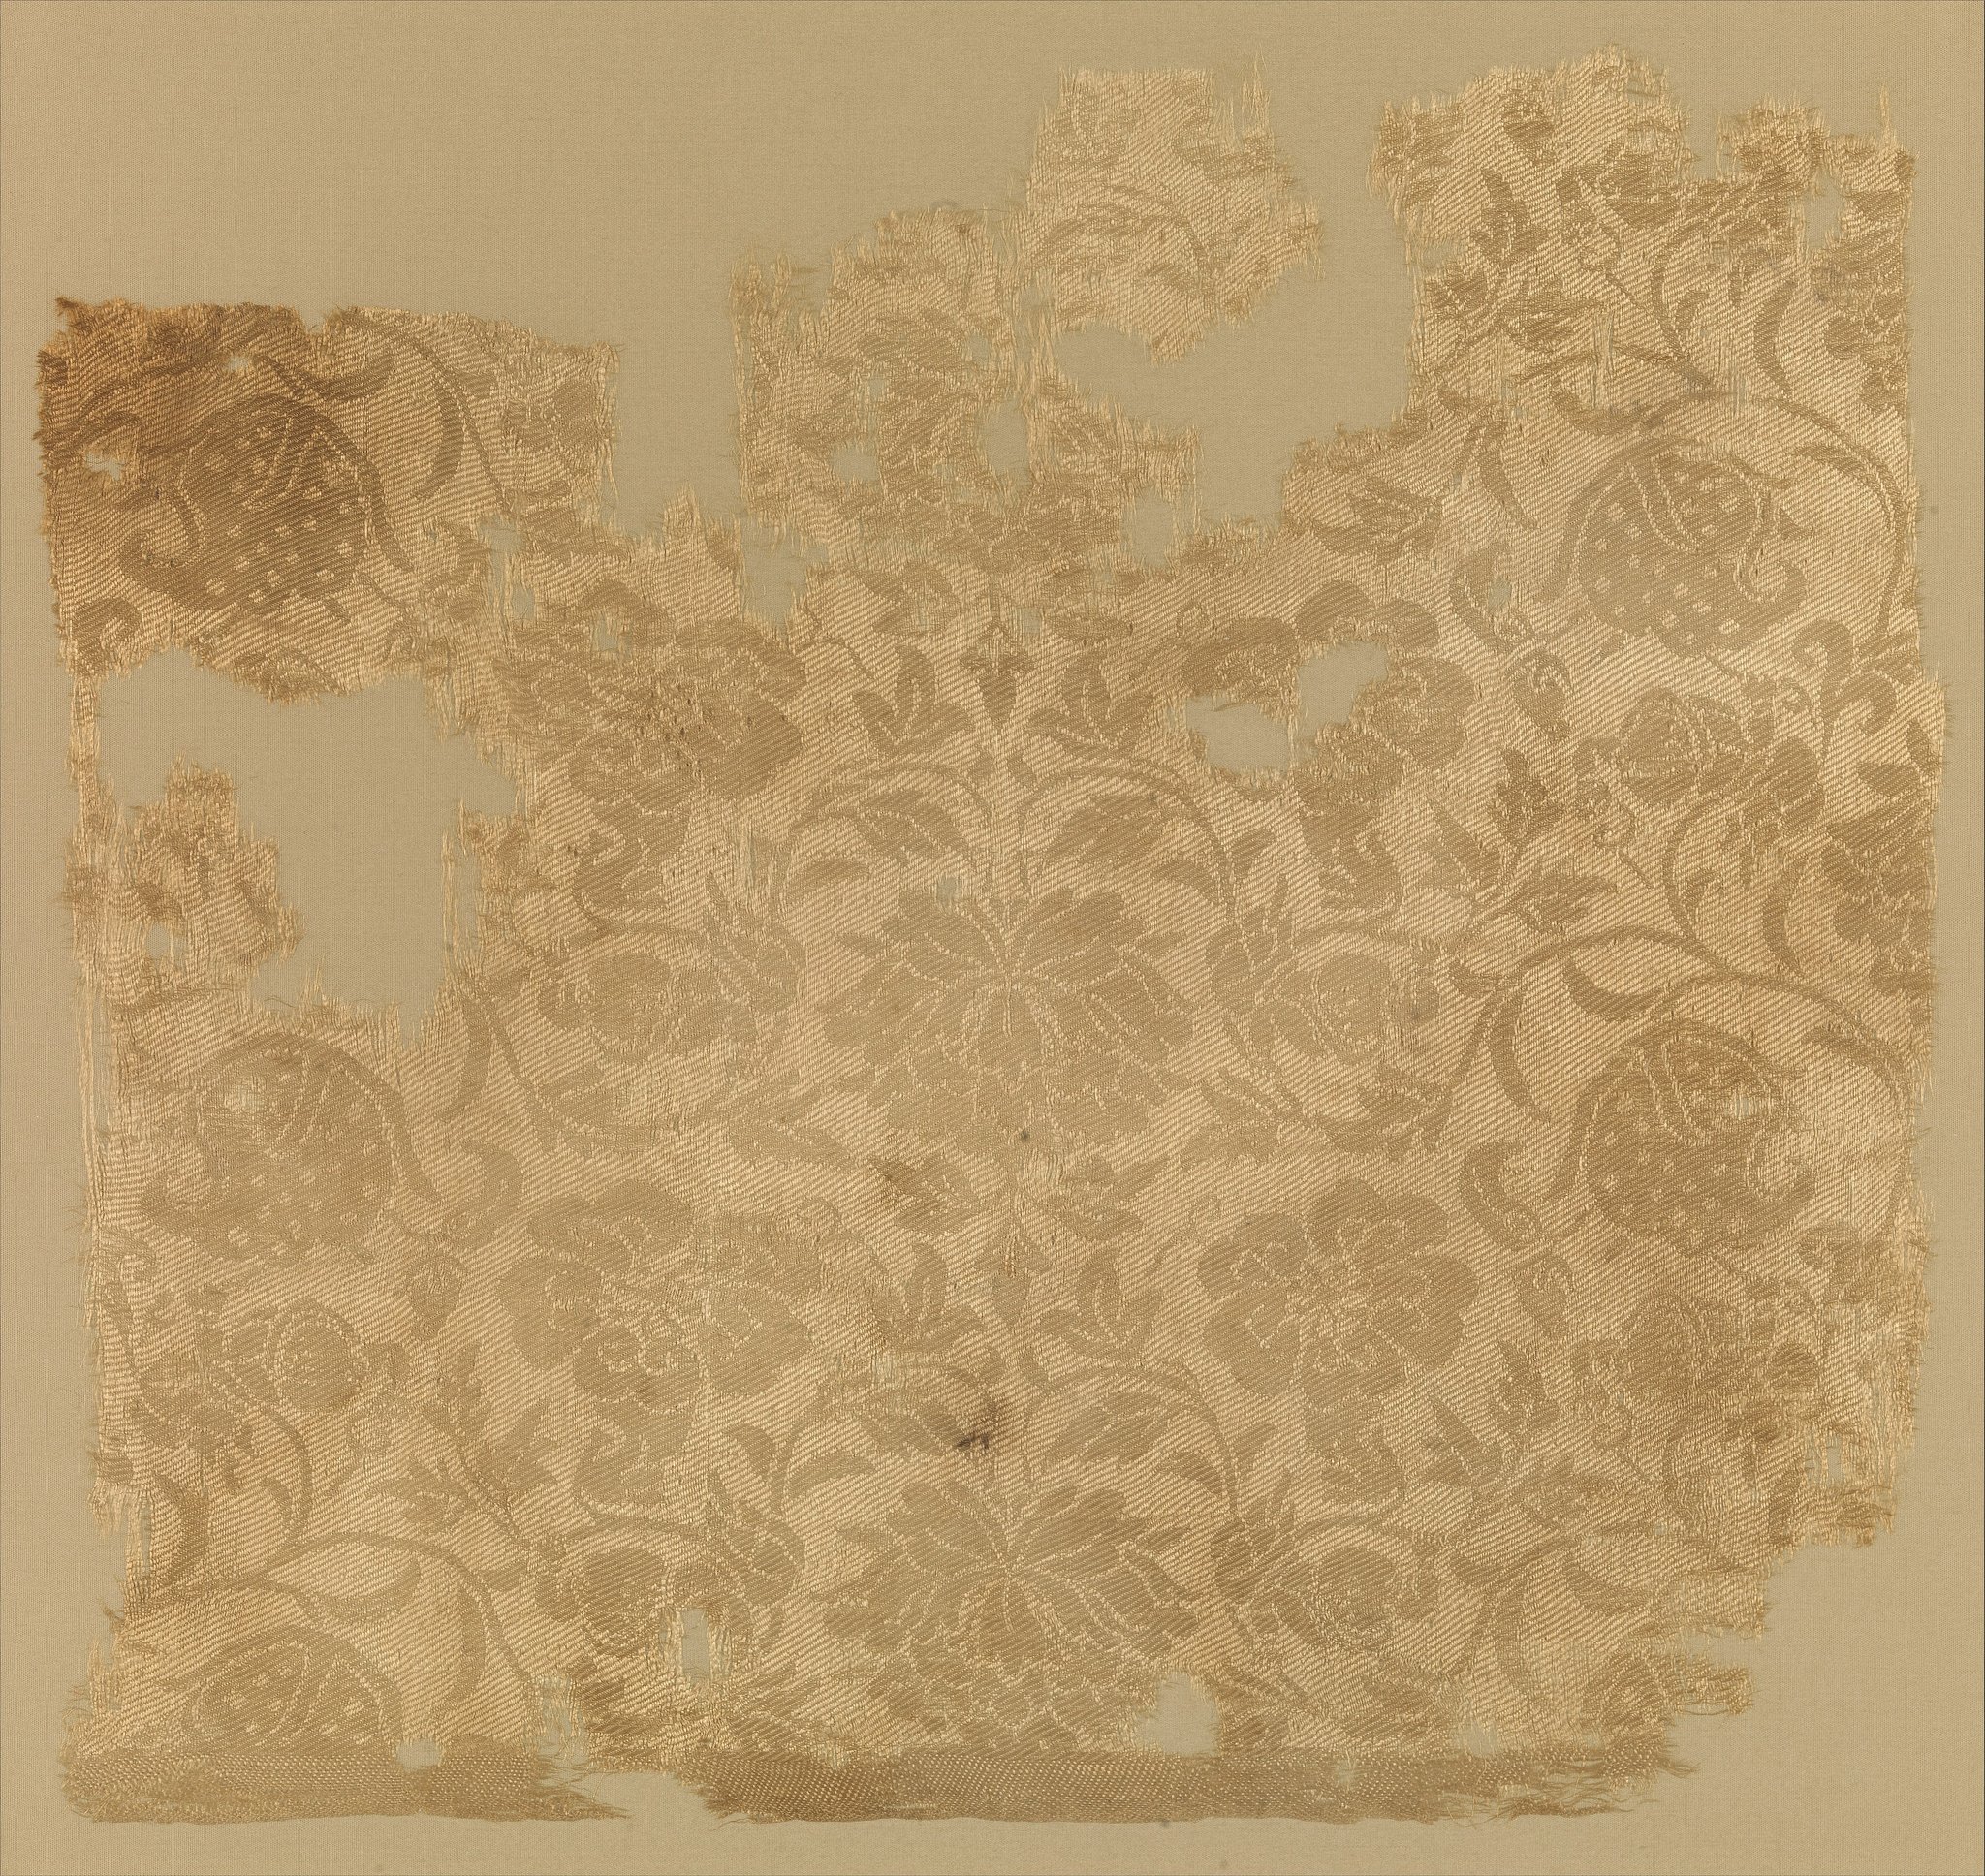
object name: fragment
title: Textile fragment with boys in floral scrolls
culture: chinese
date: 1001-1200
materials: silk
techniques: damask, weave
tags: flowers